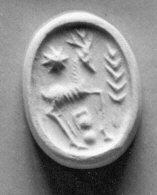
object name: stamp seal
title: Stamp seal (scaraboid) with animal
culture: assyrian or syro-anatolian-levantine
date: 900-601 BCE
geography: northern syria or southeastern anatolia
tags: animals